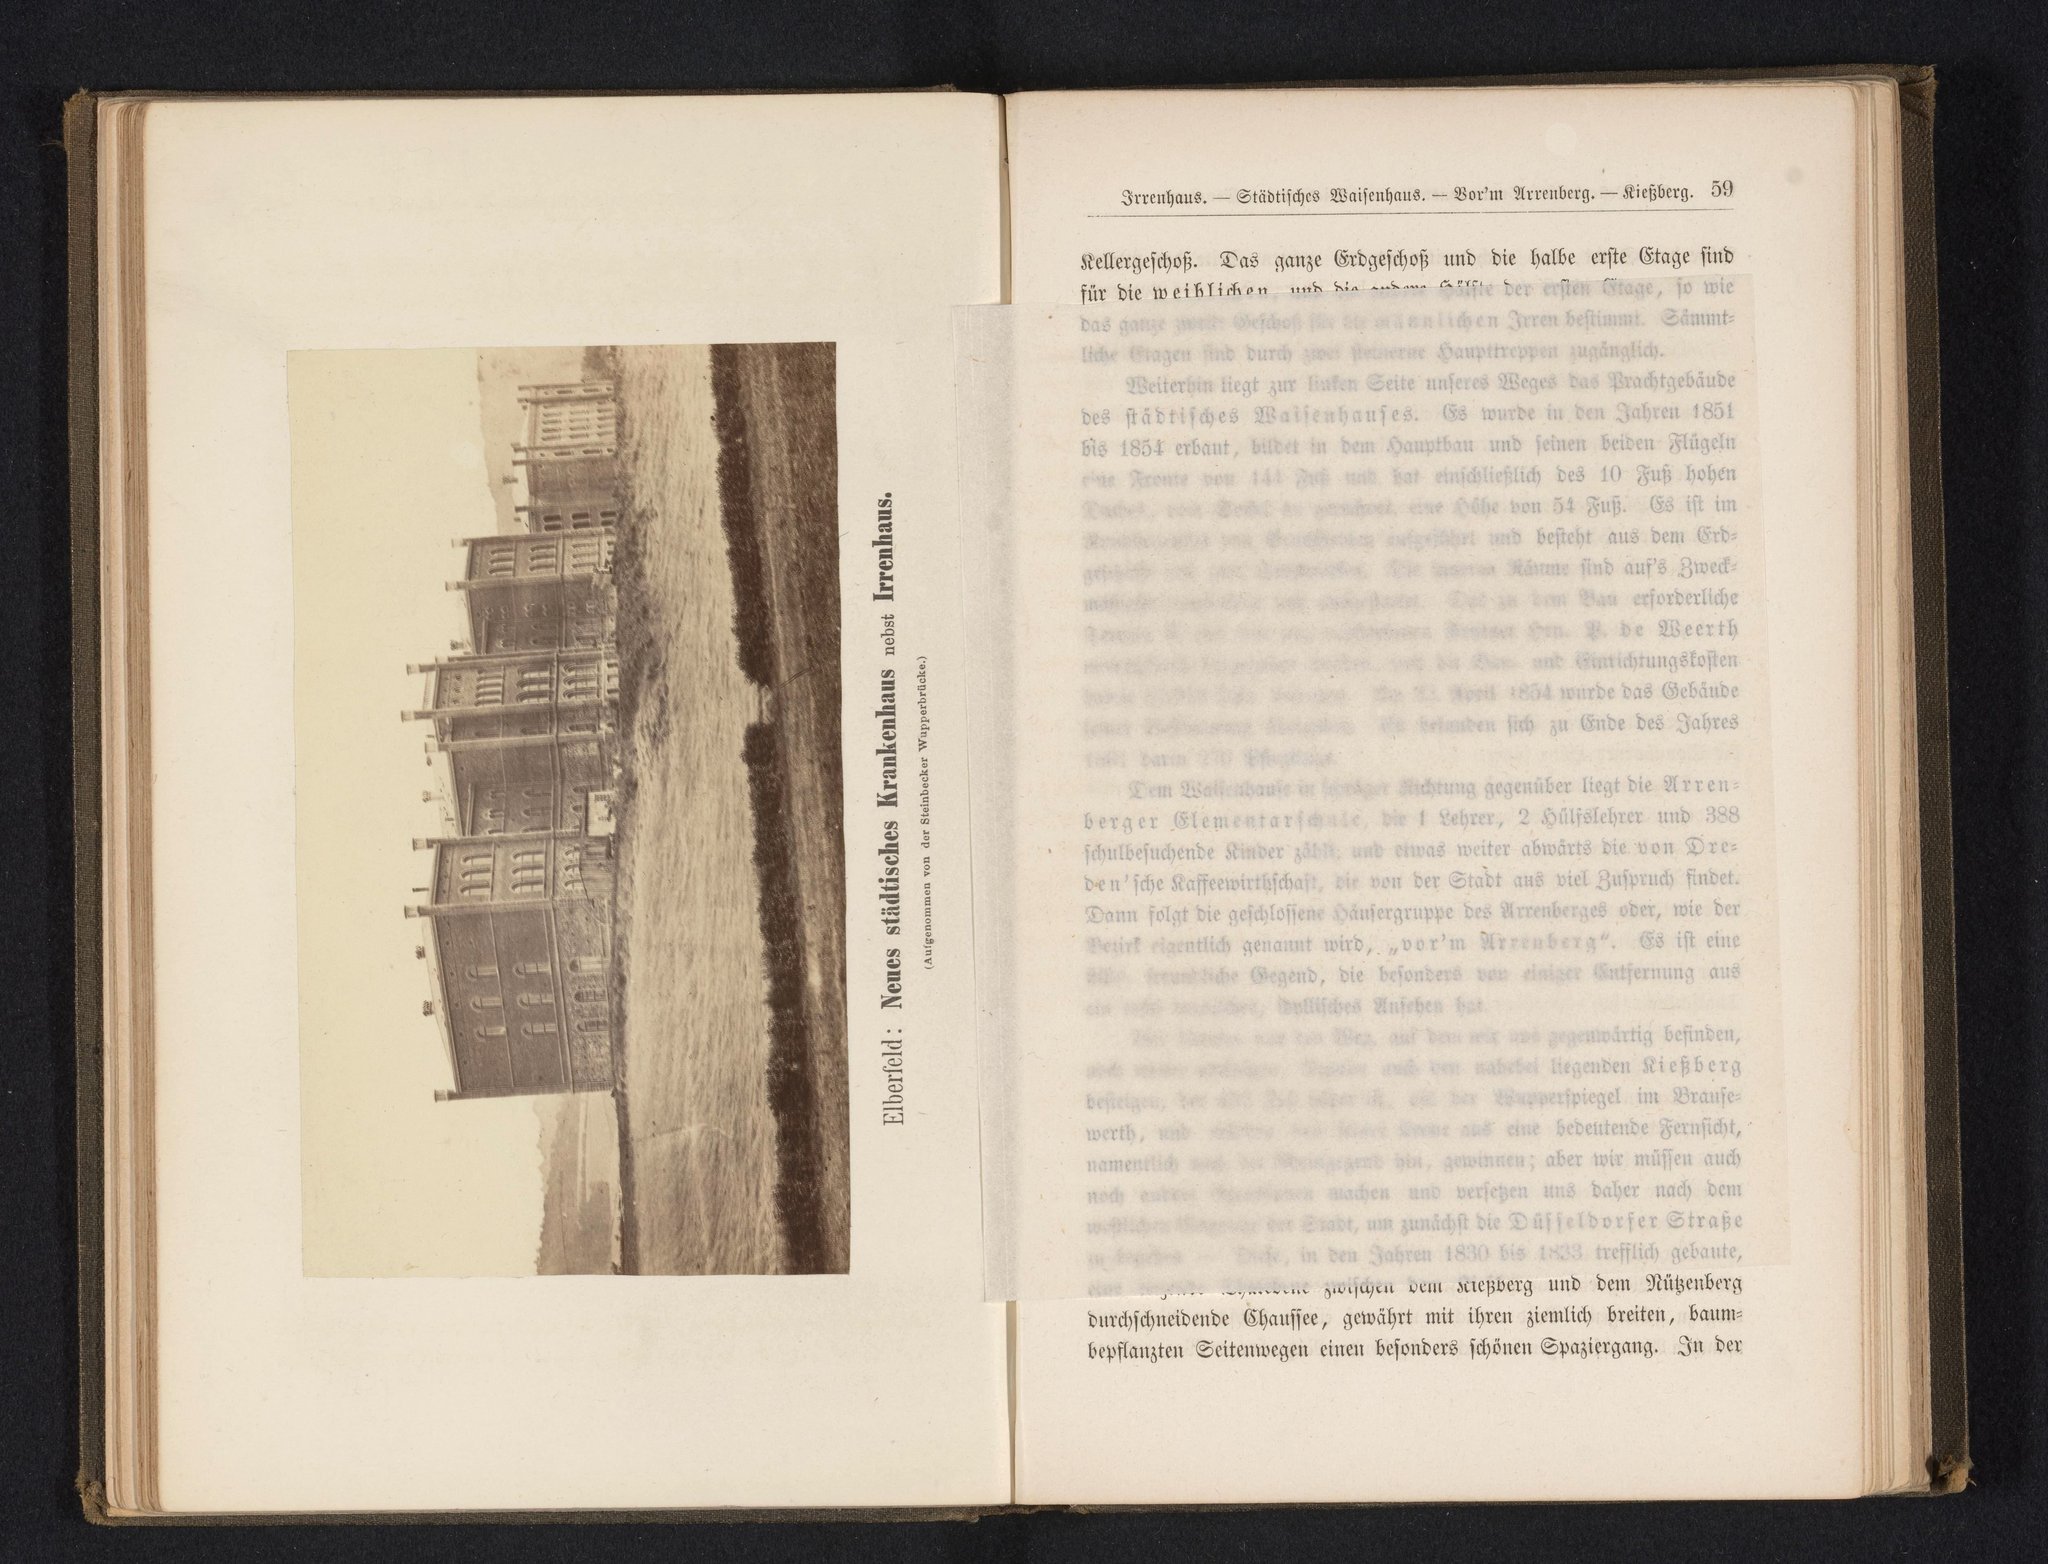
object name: page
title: Elberfeld : Neues städtisches Krankenhaus nebst Irrenhaus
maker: Anonymous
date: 1853-1863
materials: photographic support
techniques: albumen print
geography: elberfeld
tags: hospital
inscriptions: inscription: ‘(Aufgenommen von der Steinbecker Wupperbrücke.)’